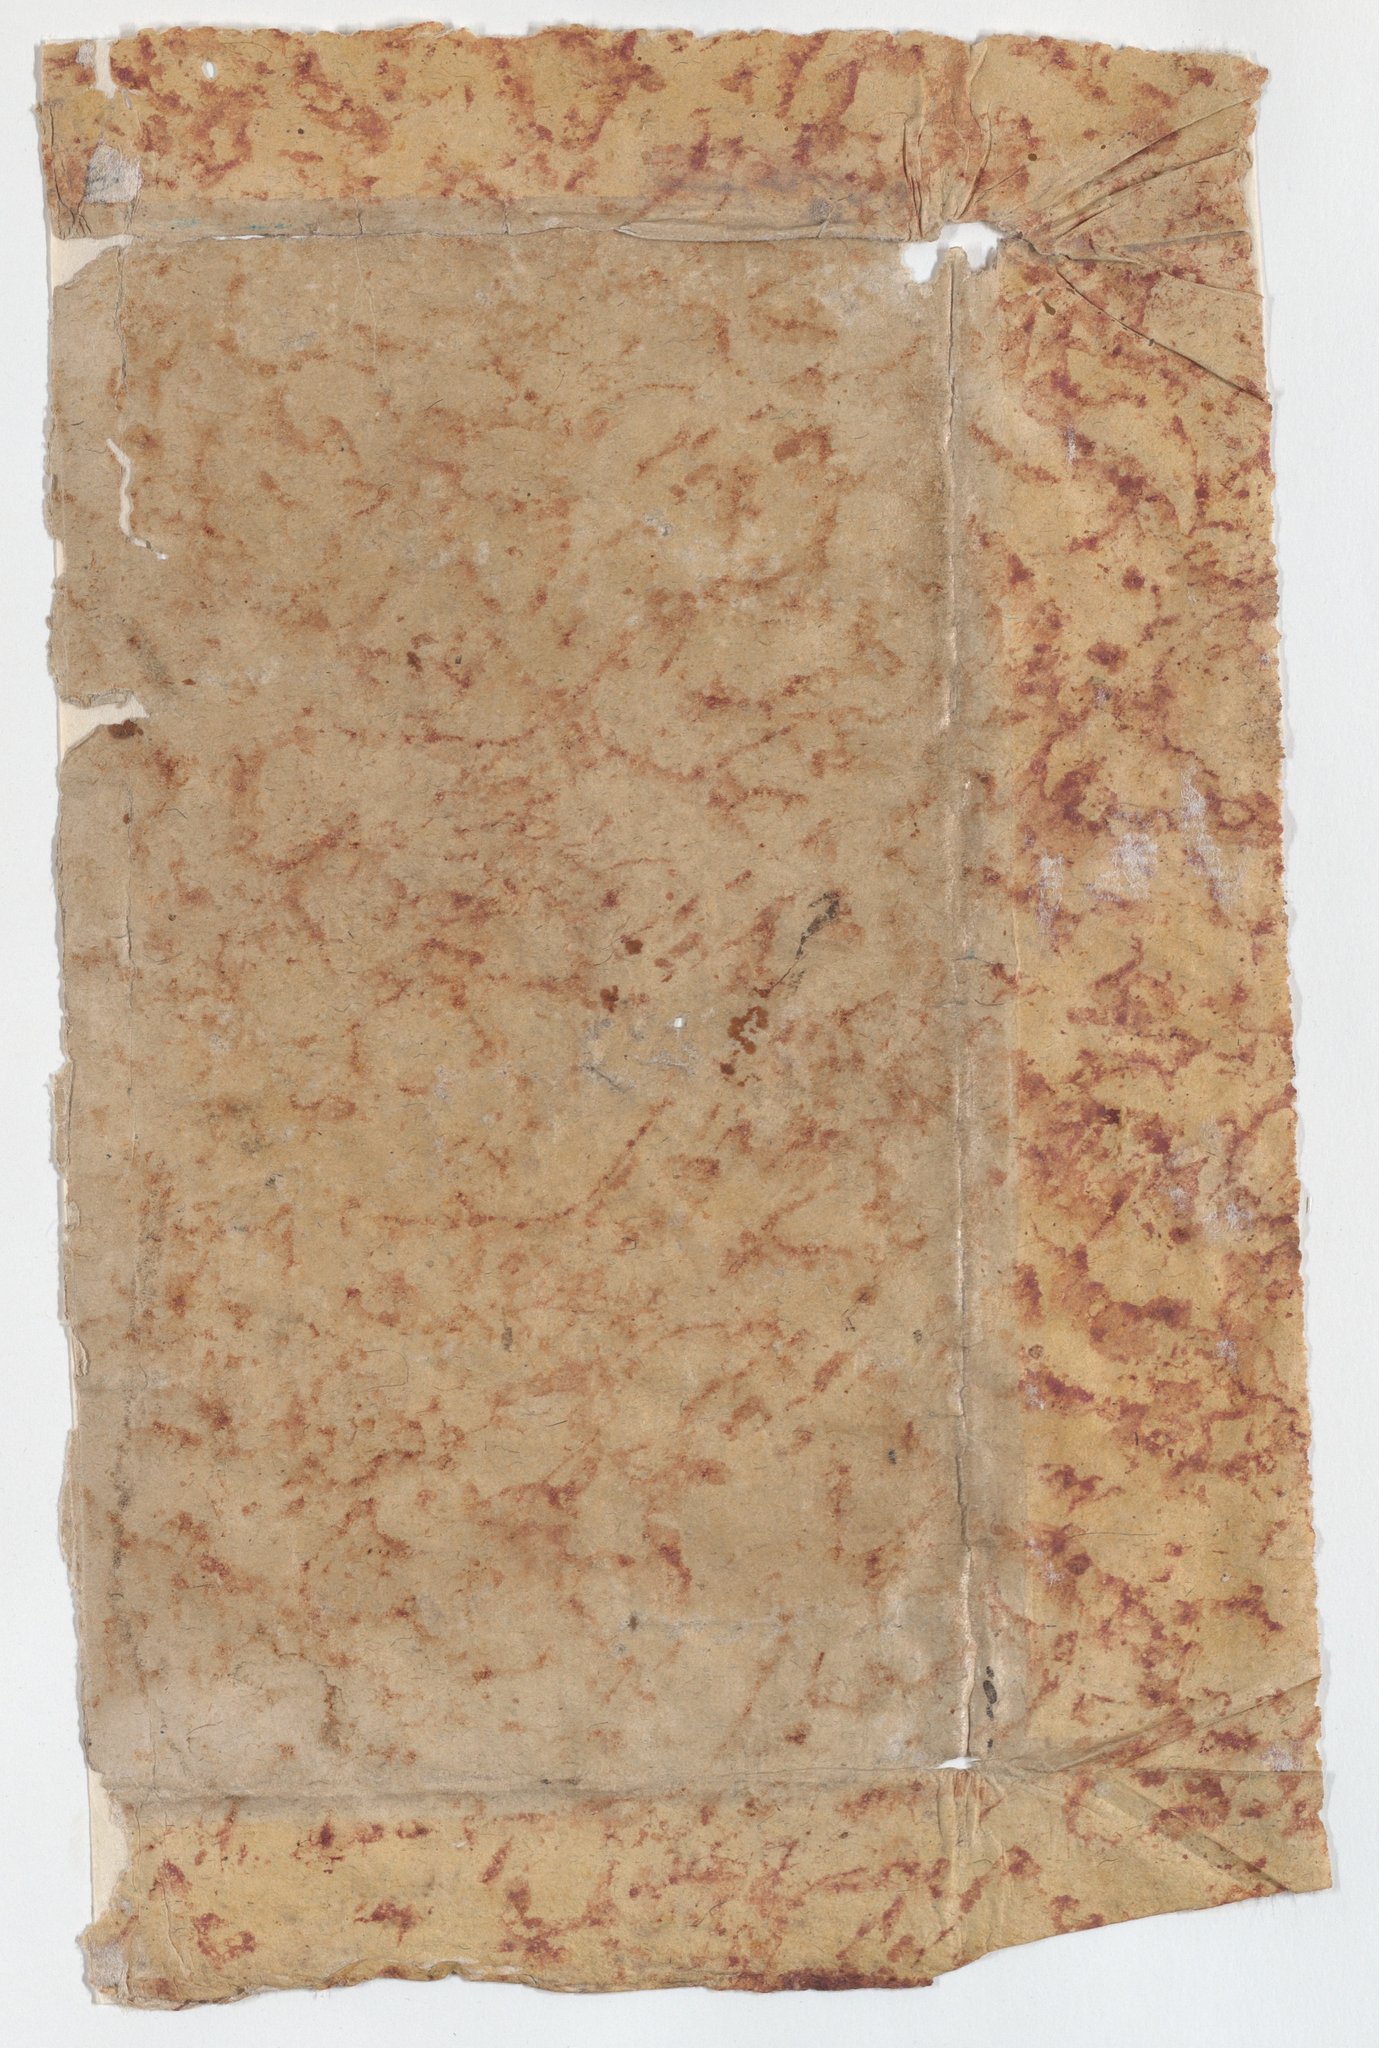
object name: print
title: Sheet with overall splotchy pattern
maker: Anonymous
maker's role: artist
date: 1801-1900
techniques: relief print